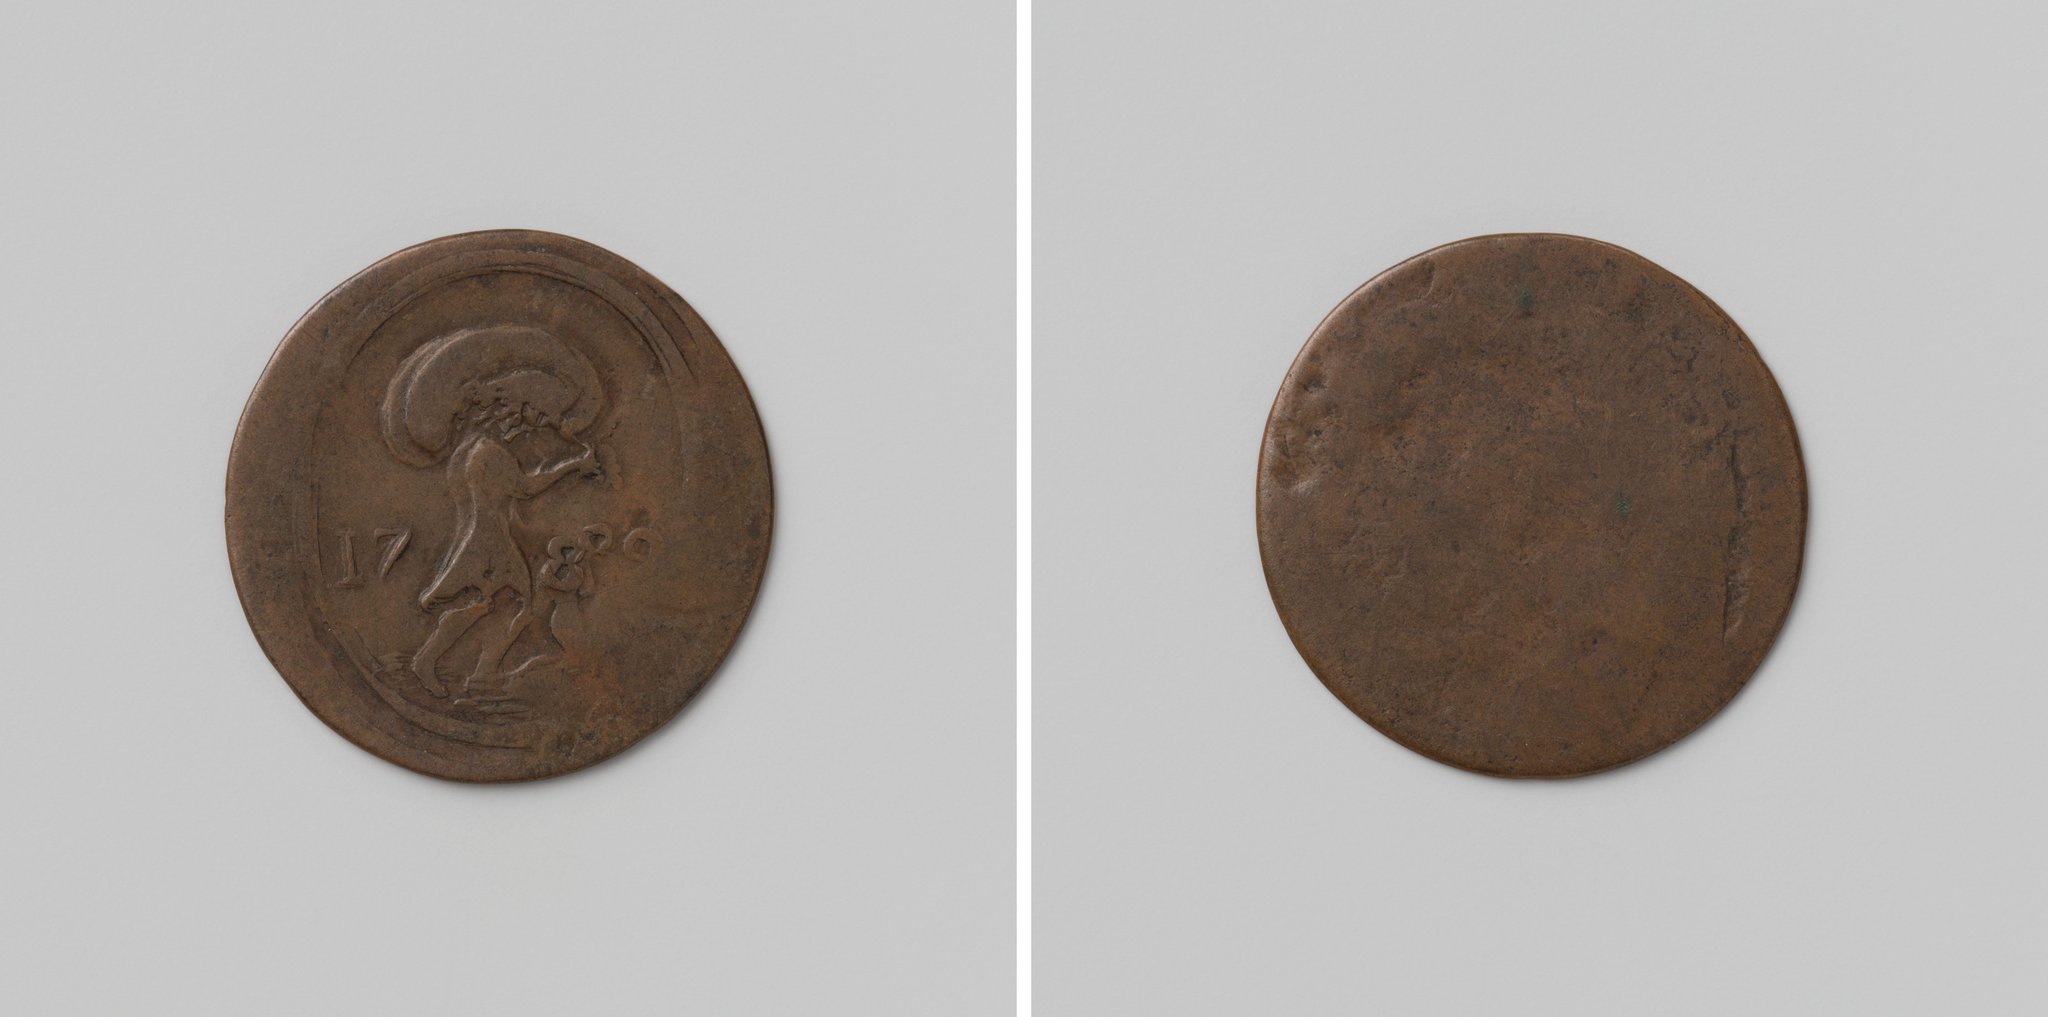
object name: medal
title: Zakkendragersgilde, gildepenning waarschijnlijk vervaardigd uit afgevijlde munt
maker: Anonymous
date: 1789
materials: copper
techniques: striking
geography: belgium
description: Eenzijdige koperen penning. Voorzijde: in ovale stempel: rechtsgewende man met zak over schouder tussen jaartal. Keerzijde: blanco.